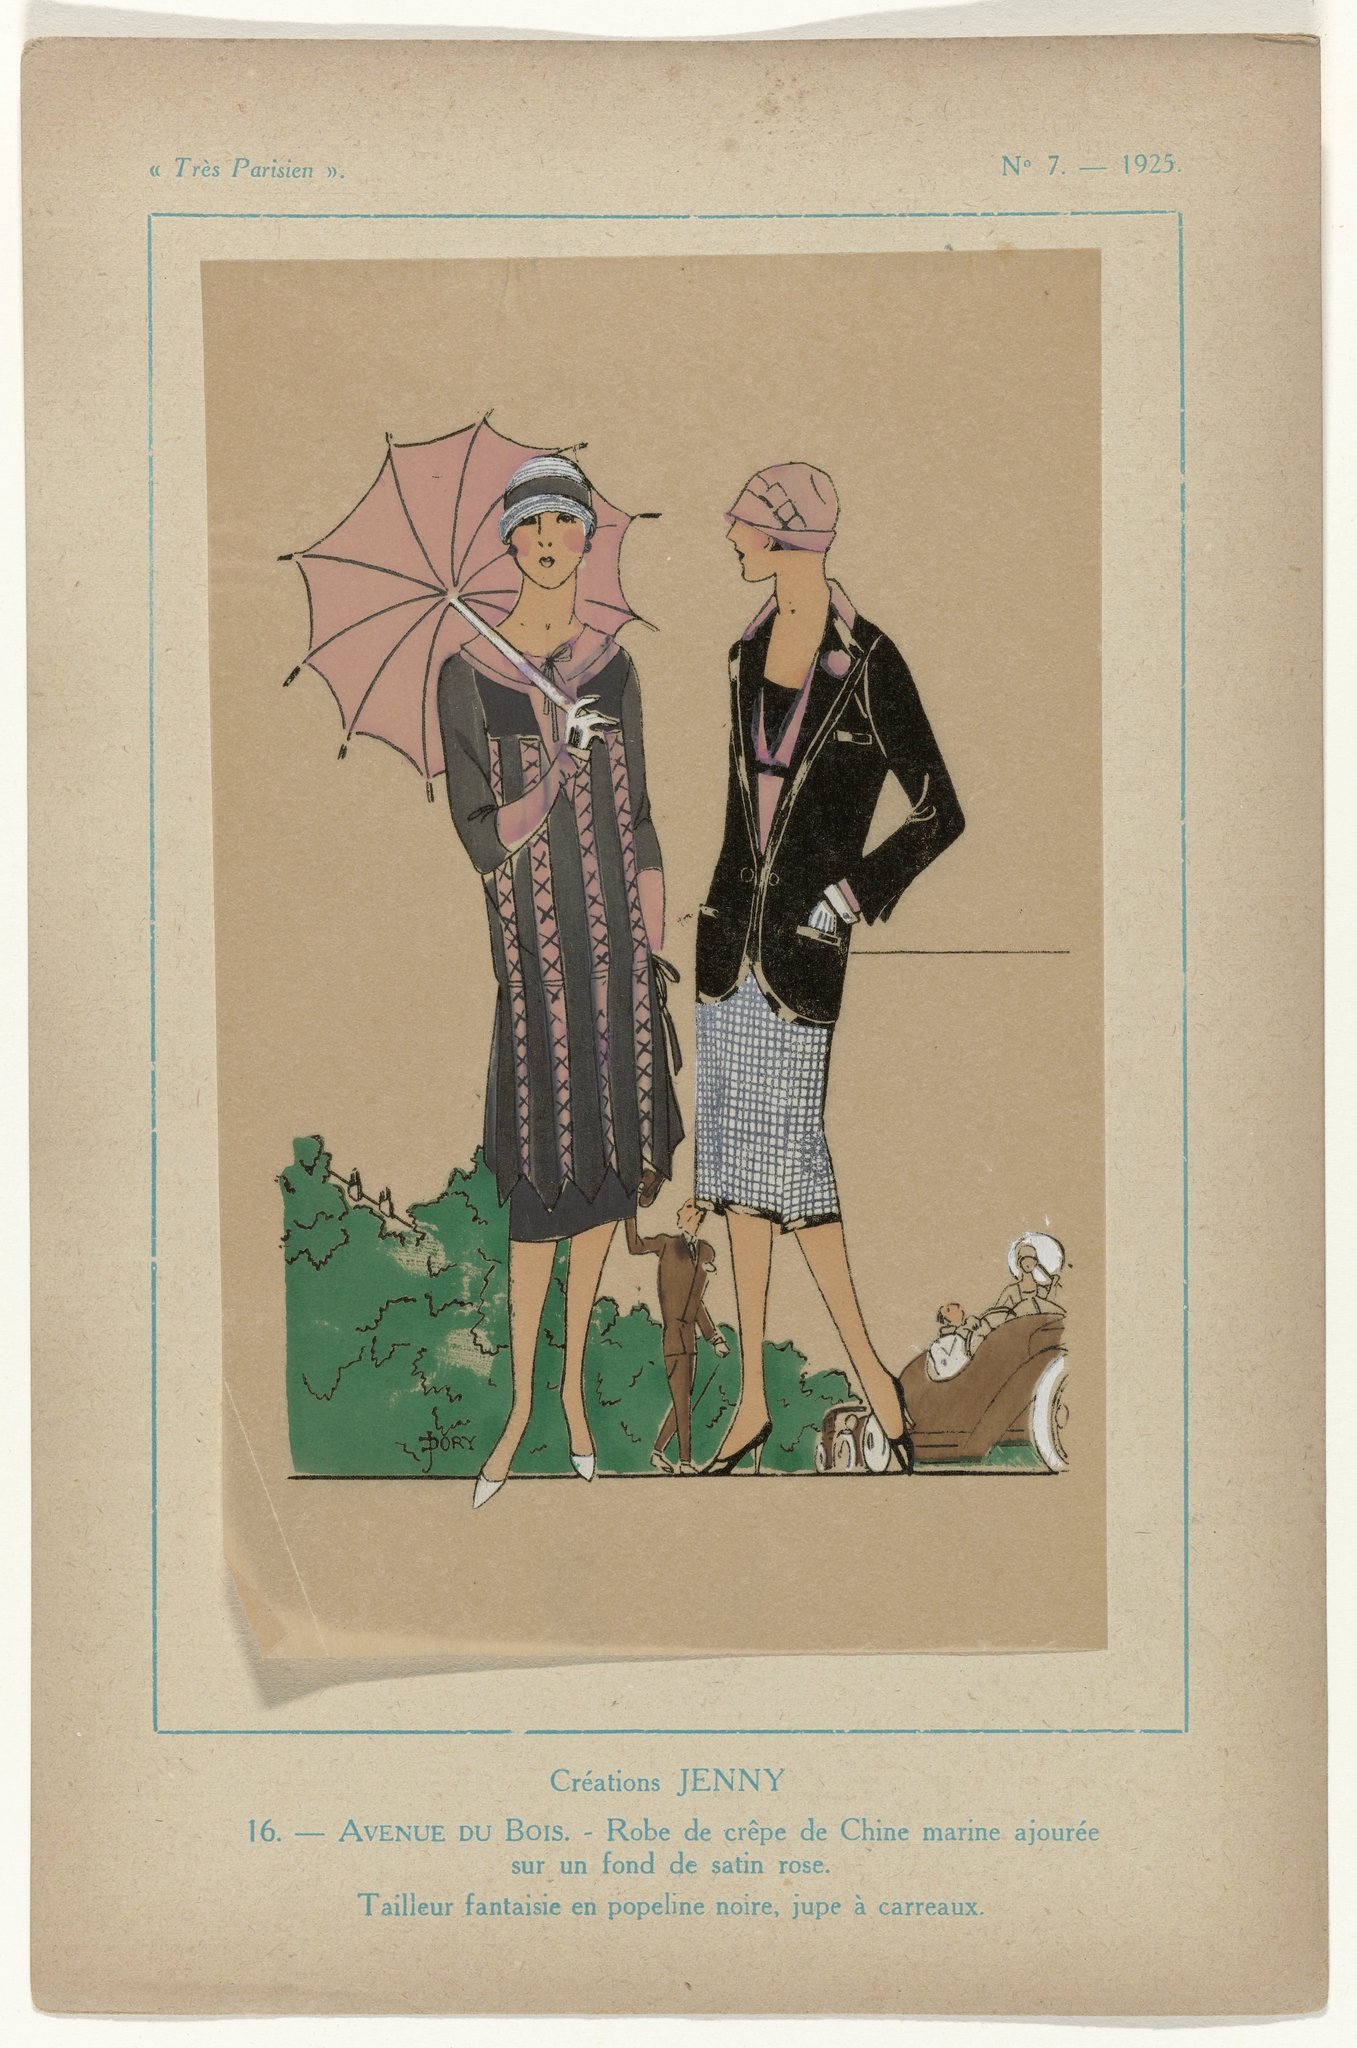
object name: fashion print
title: Très Parisien, 1925, No. 7, Pl. 16: Créations JENNY - AVENUE DU BOIS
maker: g-p. joumard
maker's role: publisher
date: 1925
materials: paper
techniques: hand coloring, letterpress printing, lithography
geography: paris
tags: dress, gown: day dress (+ women's clothes), ensembles of pieces of clothing (tailleur) (+ women's clothes), fashion plates, parasol, sunshade (+ women's clothes)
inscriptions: caption: ‘16.- AVENUE DU BOIS.- Robe de crêpe de Chine marine ajourée sur un fond de satin rose. Tailleur fantaisie en popeline noire, jupe à carreaux.’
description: Twee modellen van het modehuis Jenny. Japon van crêpe de Chine en tailleur van zwarte popeline op een geruite rok. Prent uit het modetijdschrift Très Parisien...La Mode, Le Chic, L'Élégance (1920-1936)